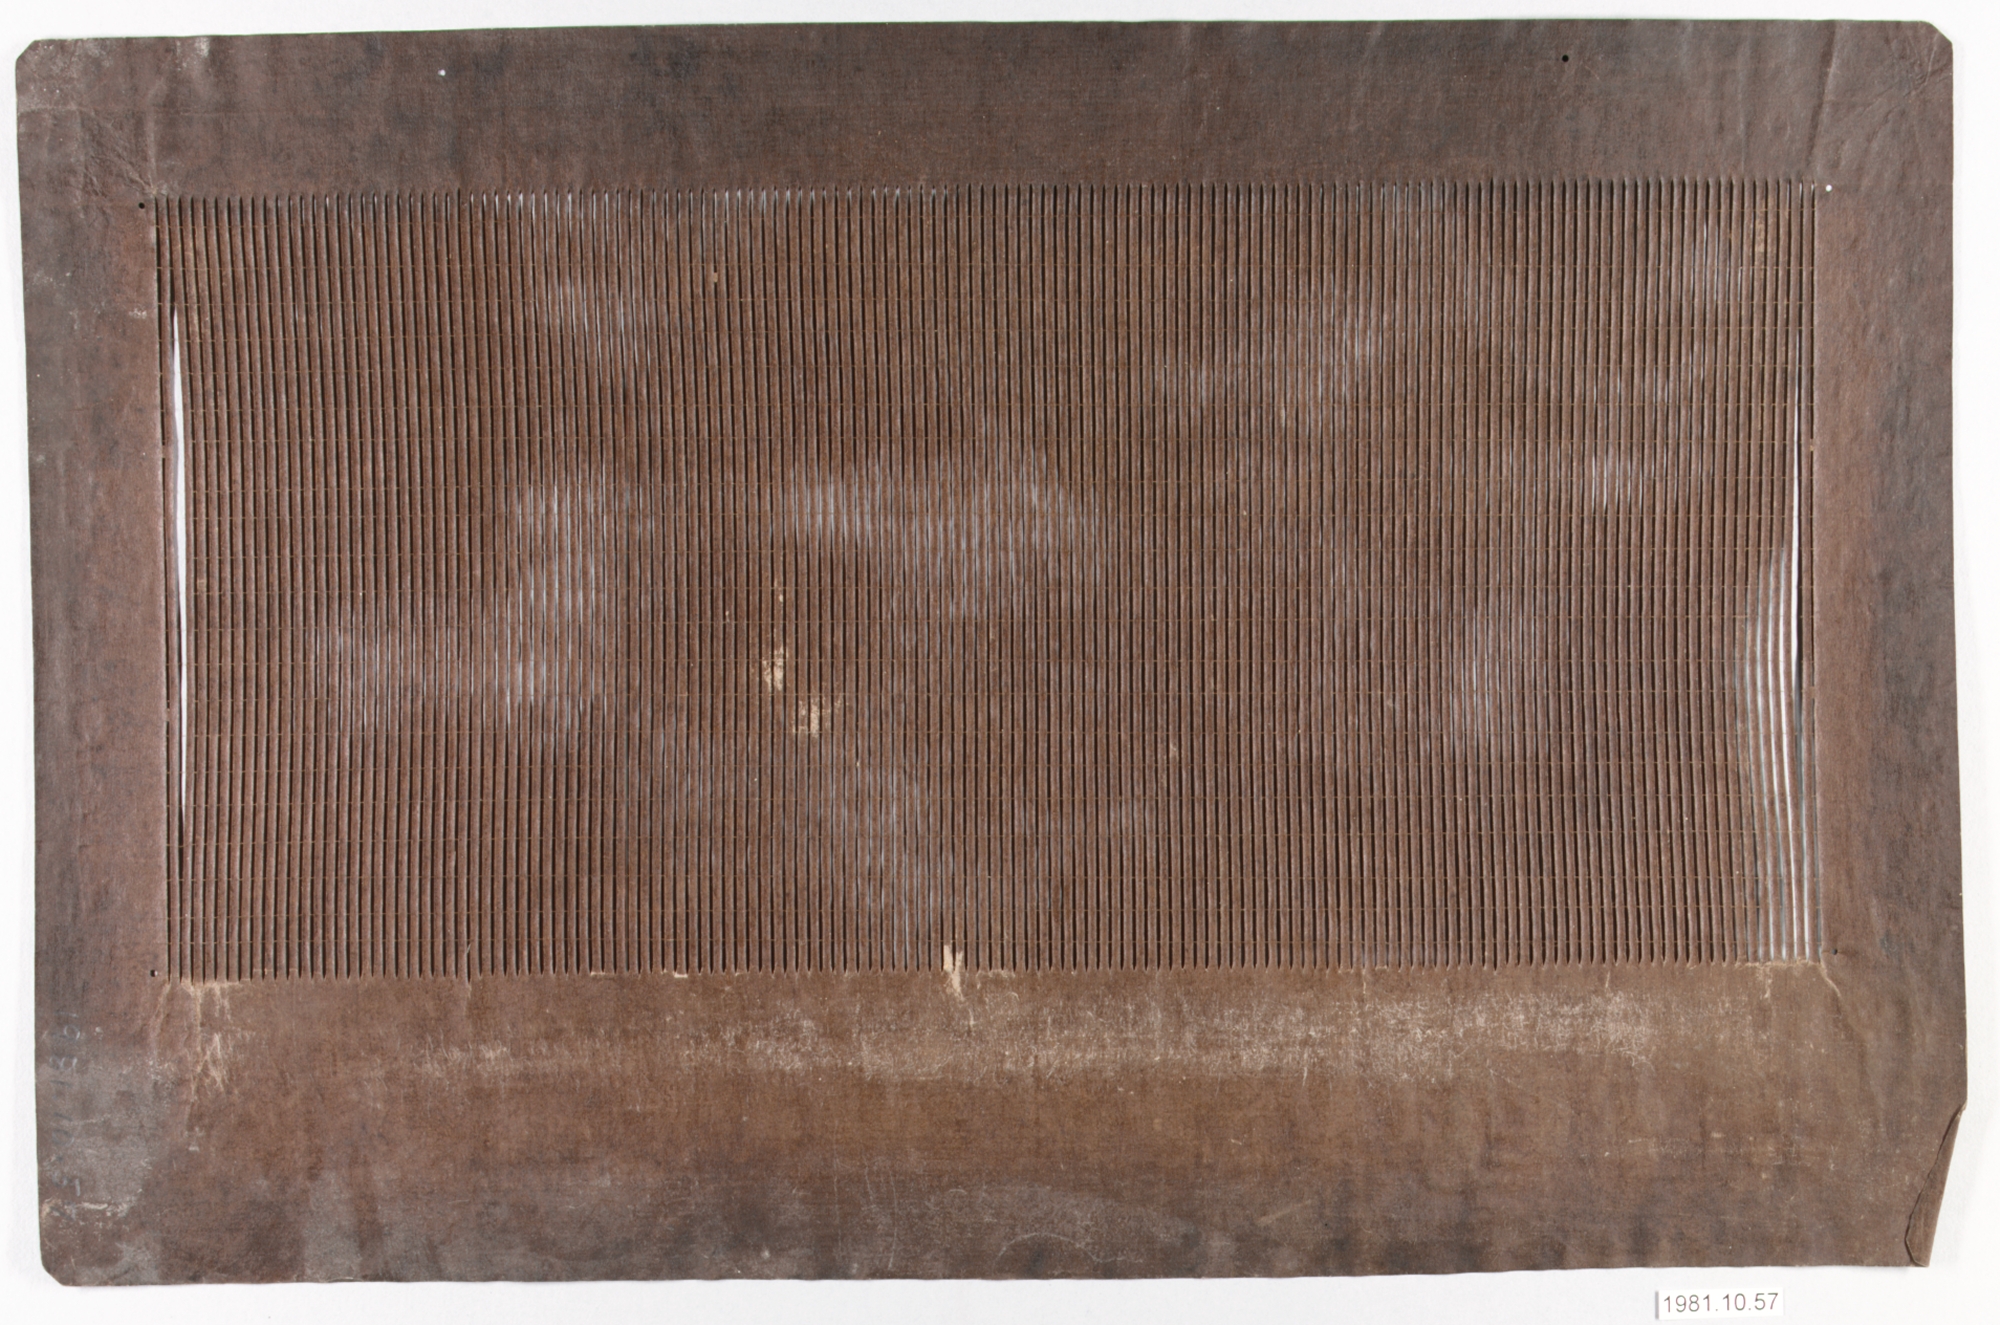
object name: stencil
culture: japanese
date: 1801-1900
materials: paper